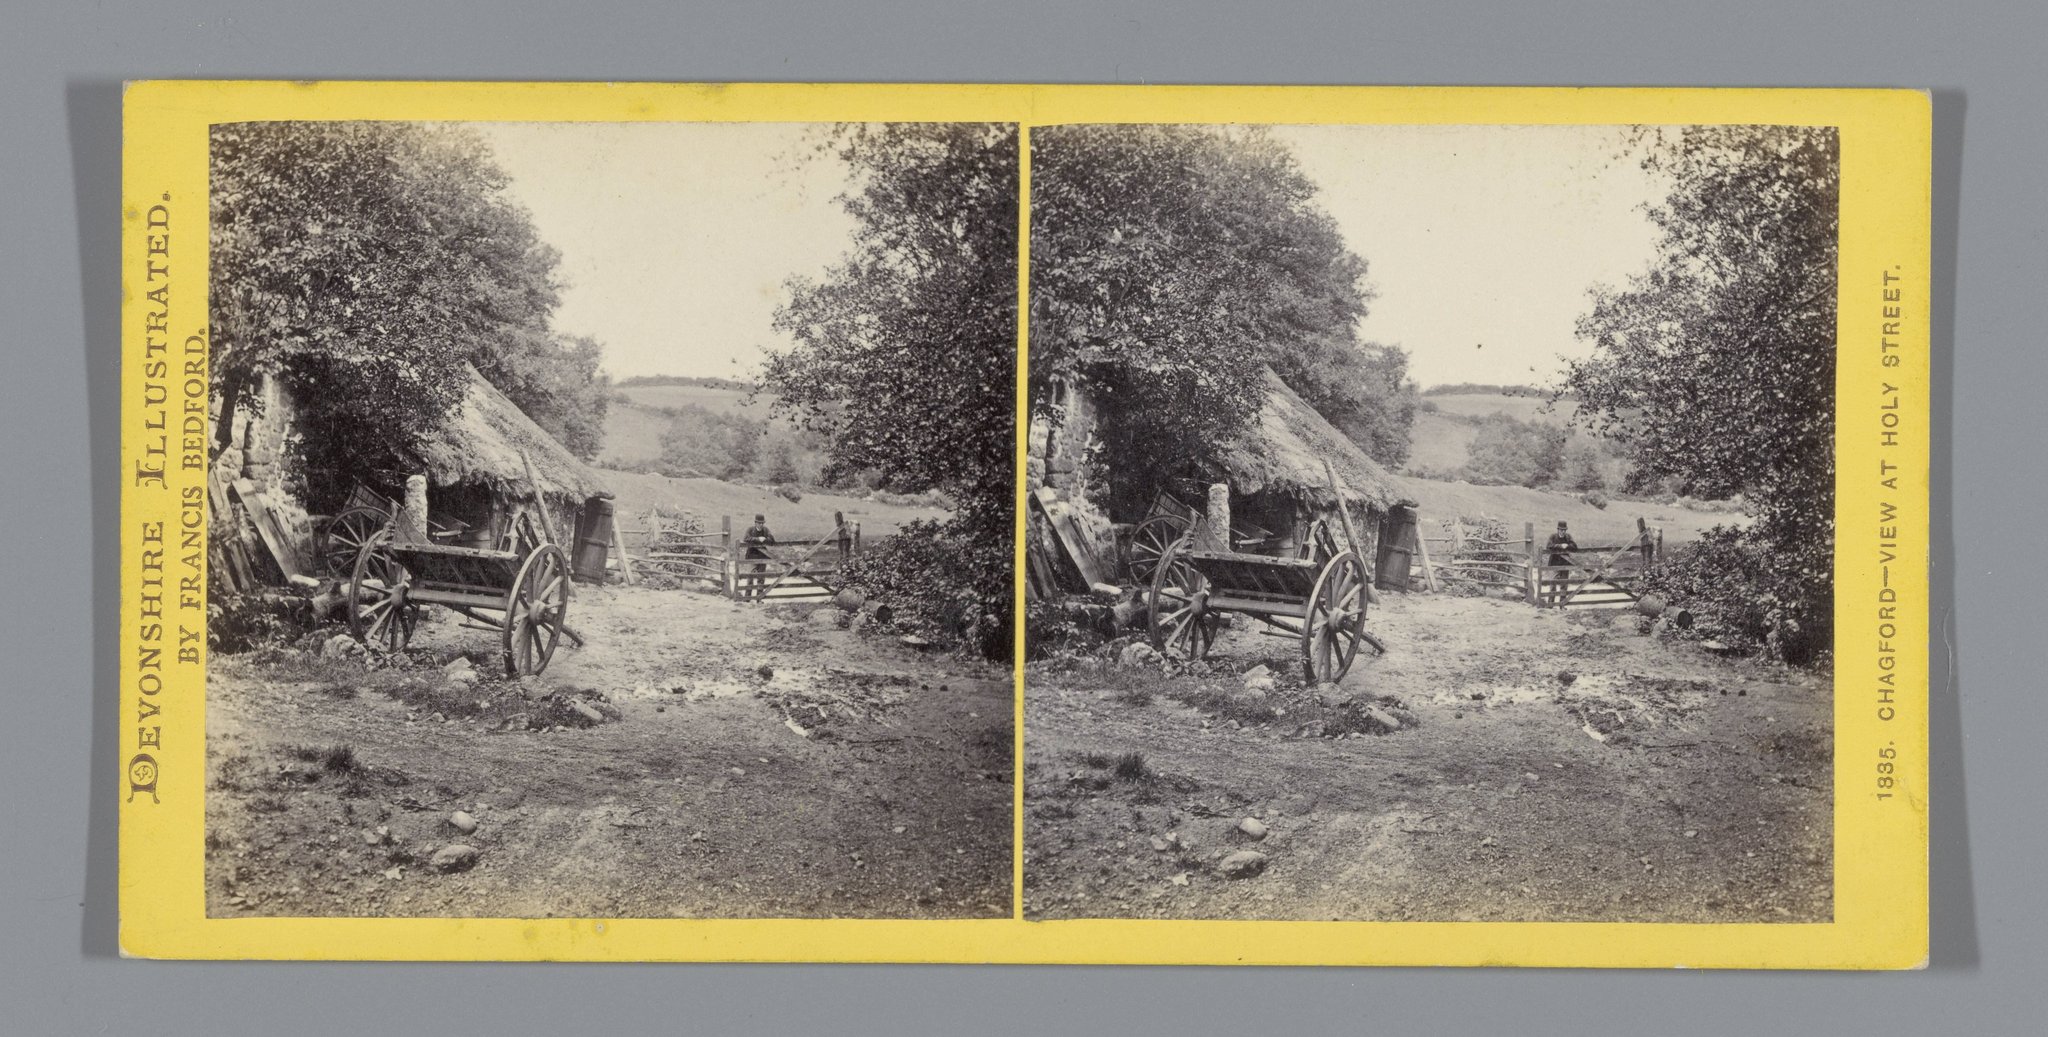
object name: stereograph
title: Chagford-View at Holy Street.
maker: francis bedford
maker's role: print maker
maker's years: 1815-1894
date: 1850-1880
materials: cardboard, photographic support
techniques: albumen print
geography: chagford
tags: hand-cart, public road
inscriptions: number: ‘1835.’, inscription: ‘Devonshire Illustrated. by Francis Bedford.’